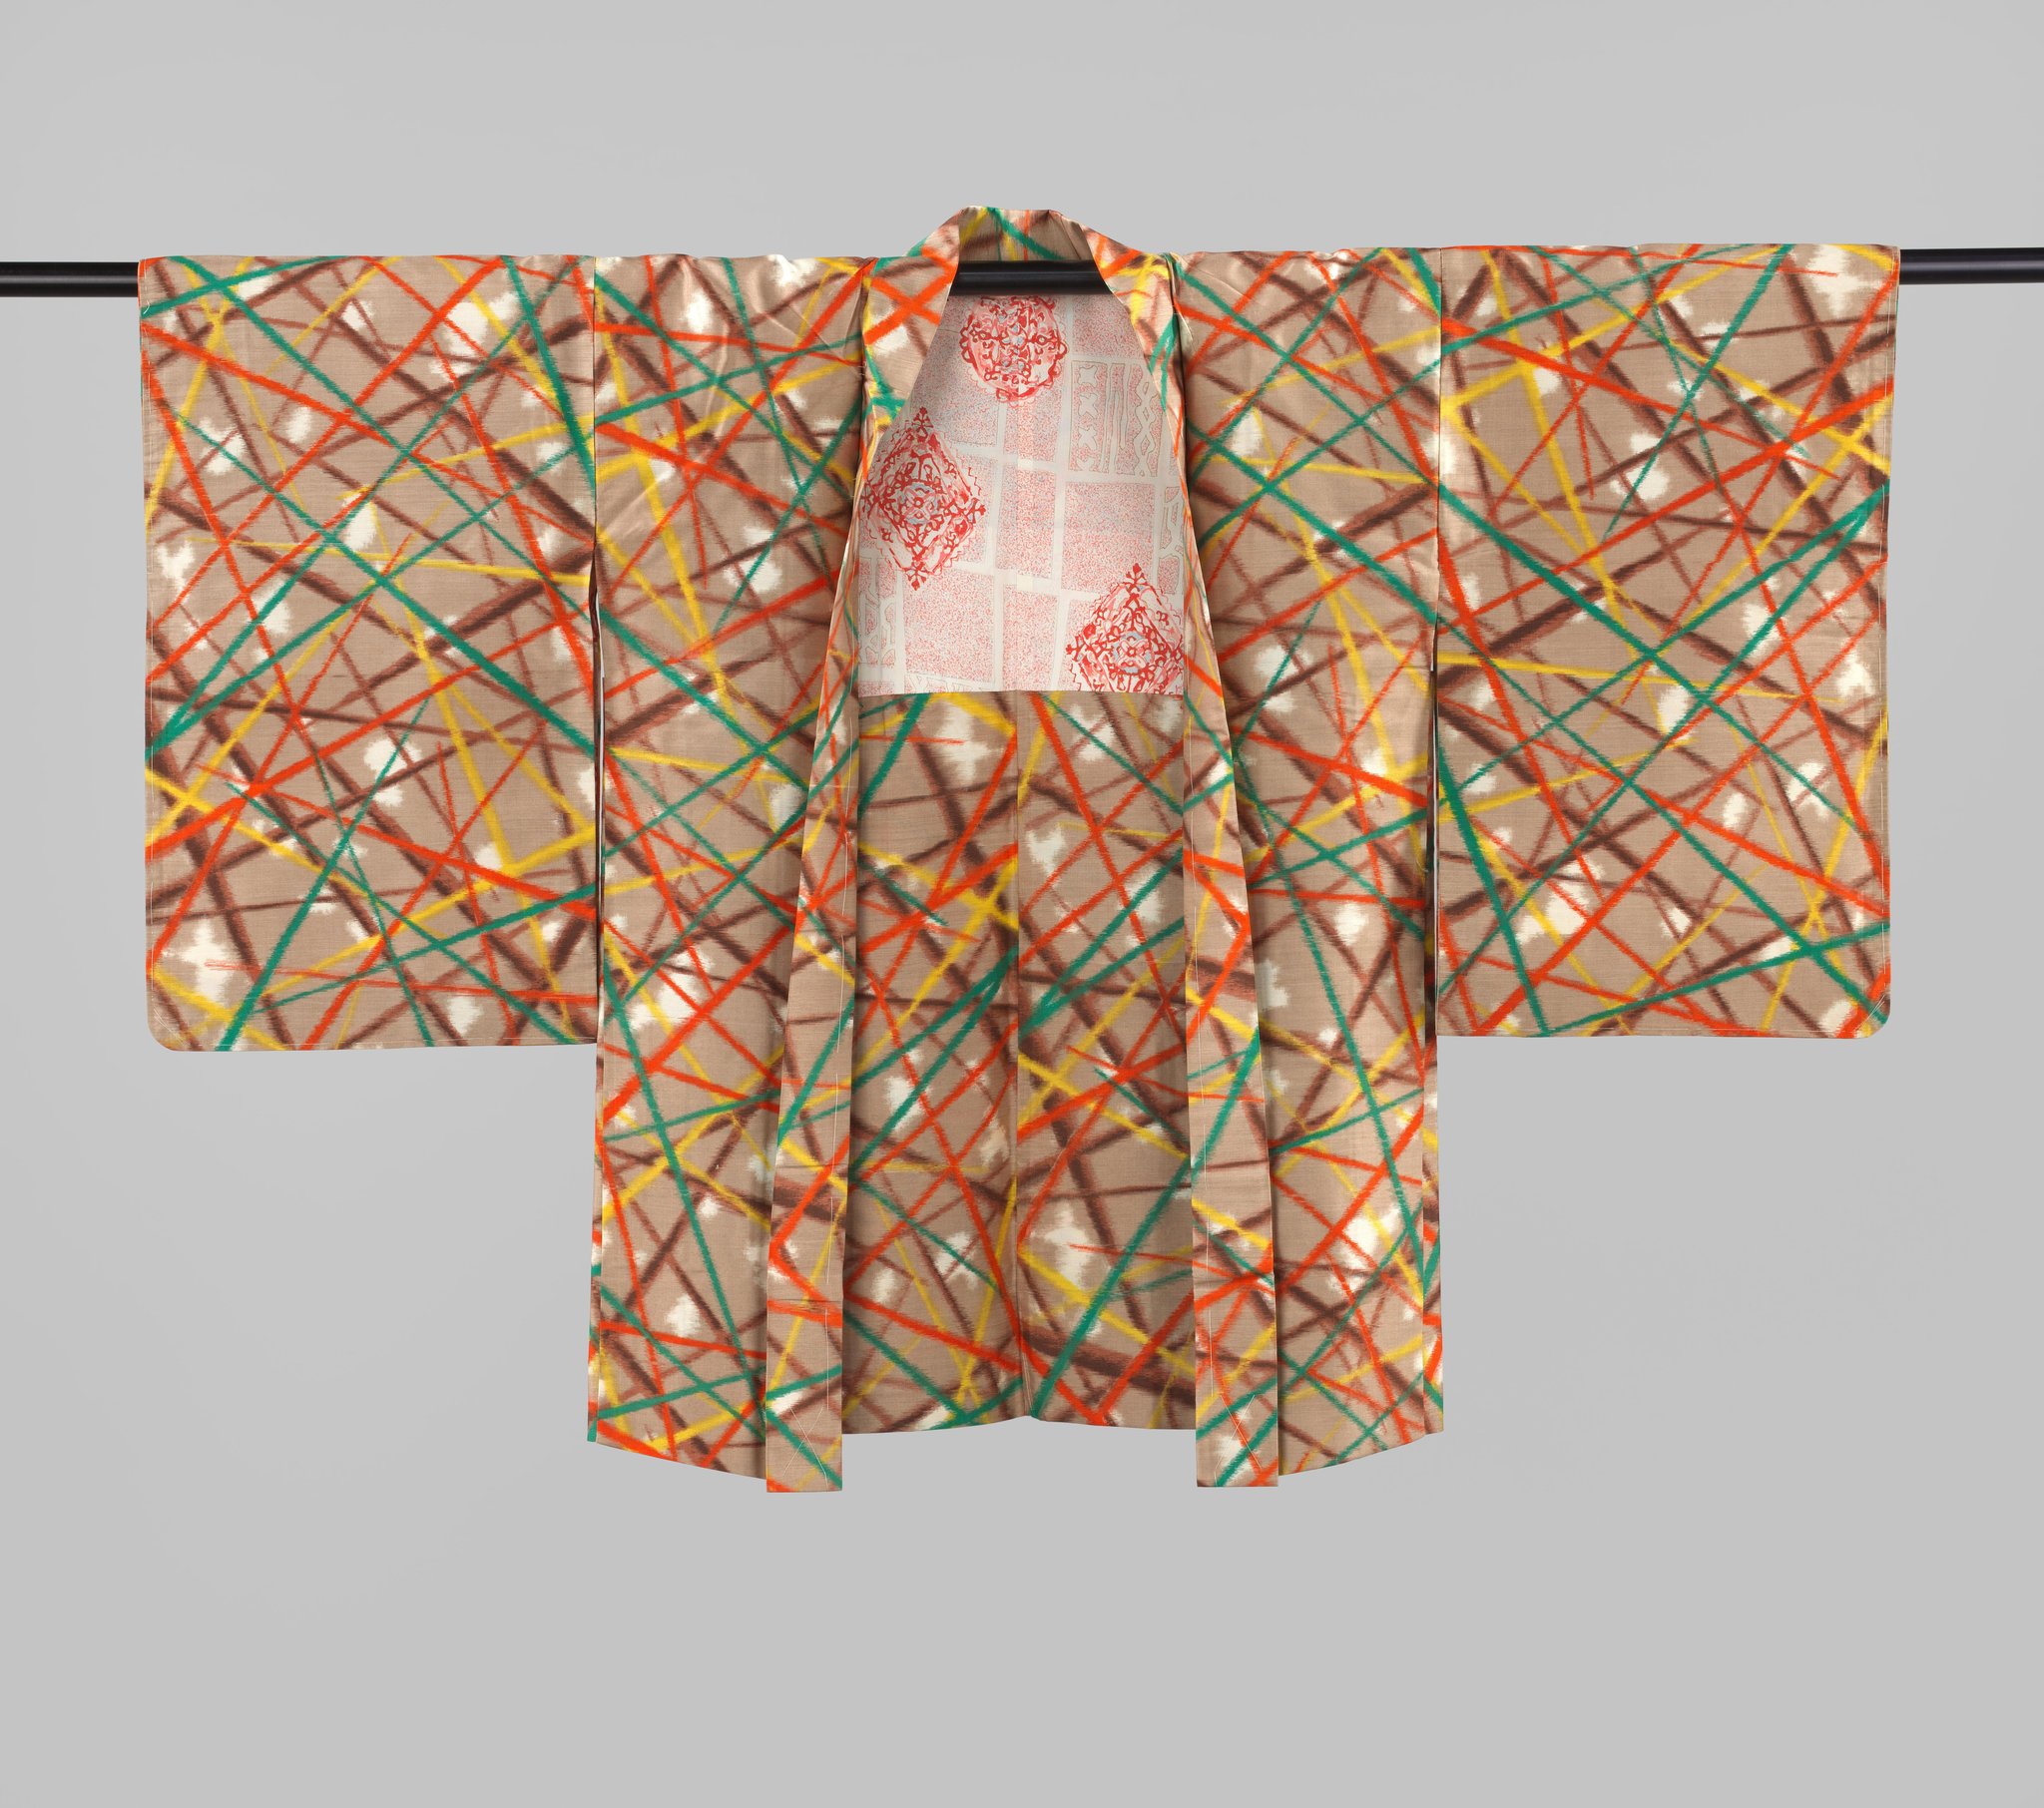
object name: kimono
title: Vrouwen haori met kleurige lijnen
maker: Anonymous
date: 1920-1940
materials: silk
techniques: painting, weave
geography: japan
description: Haori voor een vrouw met een versiering over het hele vlak van kris-kras lopende rode, groene, gele en bruine lijnen met witte stippen; wellicht een impressie van vuurwerk in de sneeuw. Beige zijde met versiering in stencil-druk (meisen). Voering van gestencilde zijde.